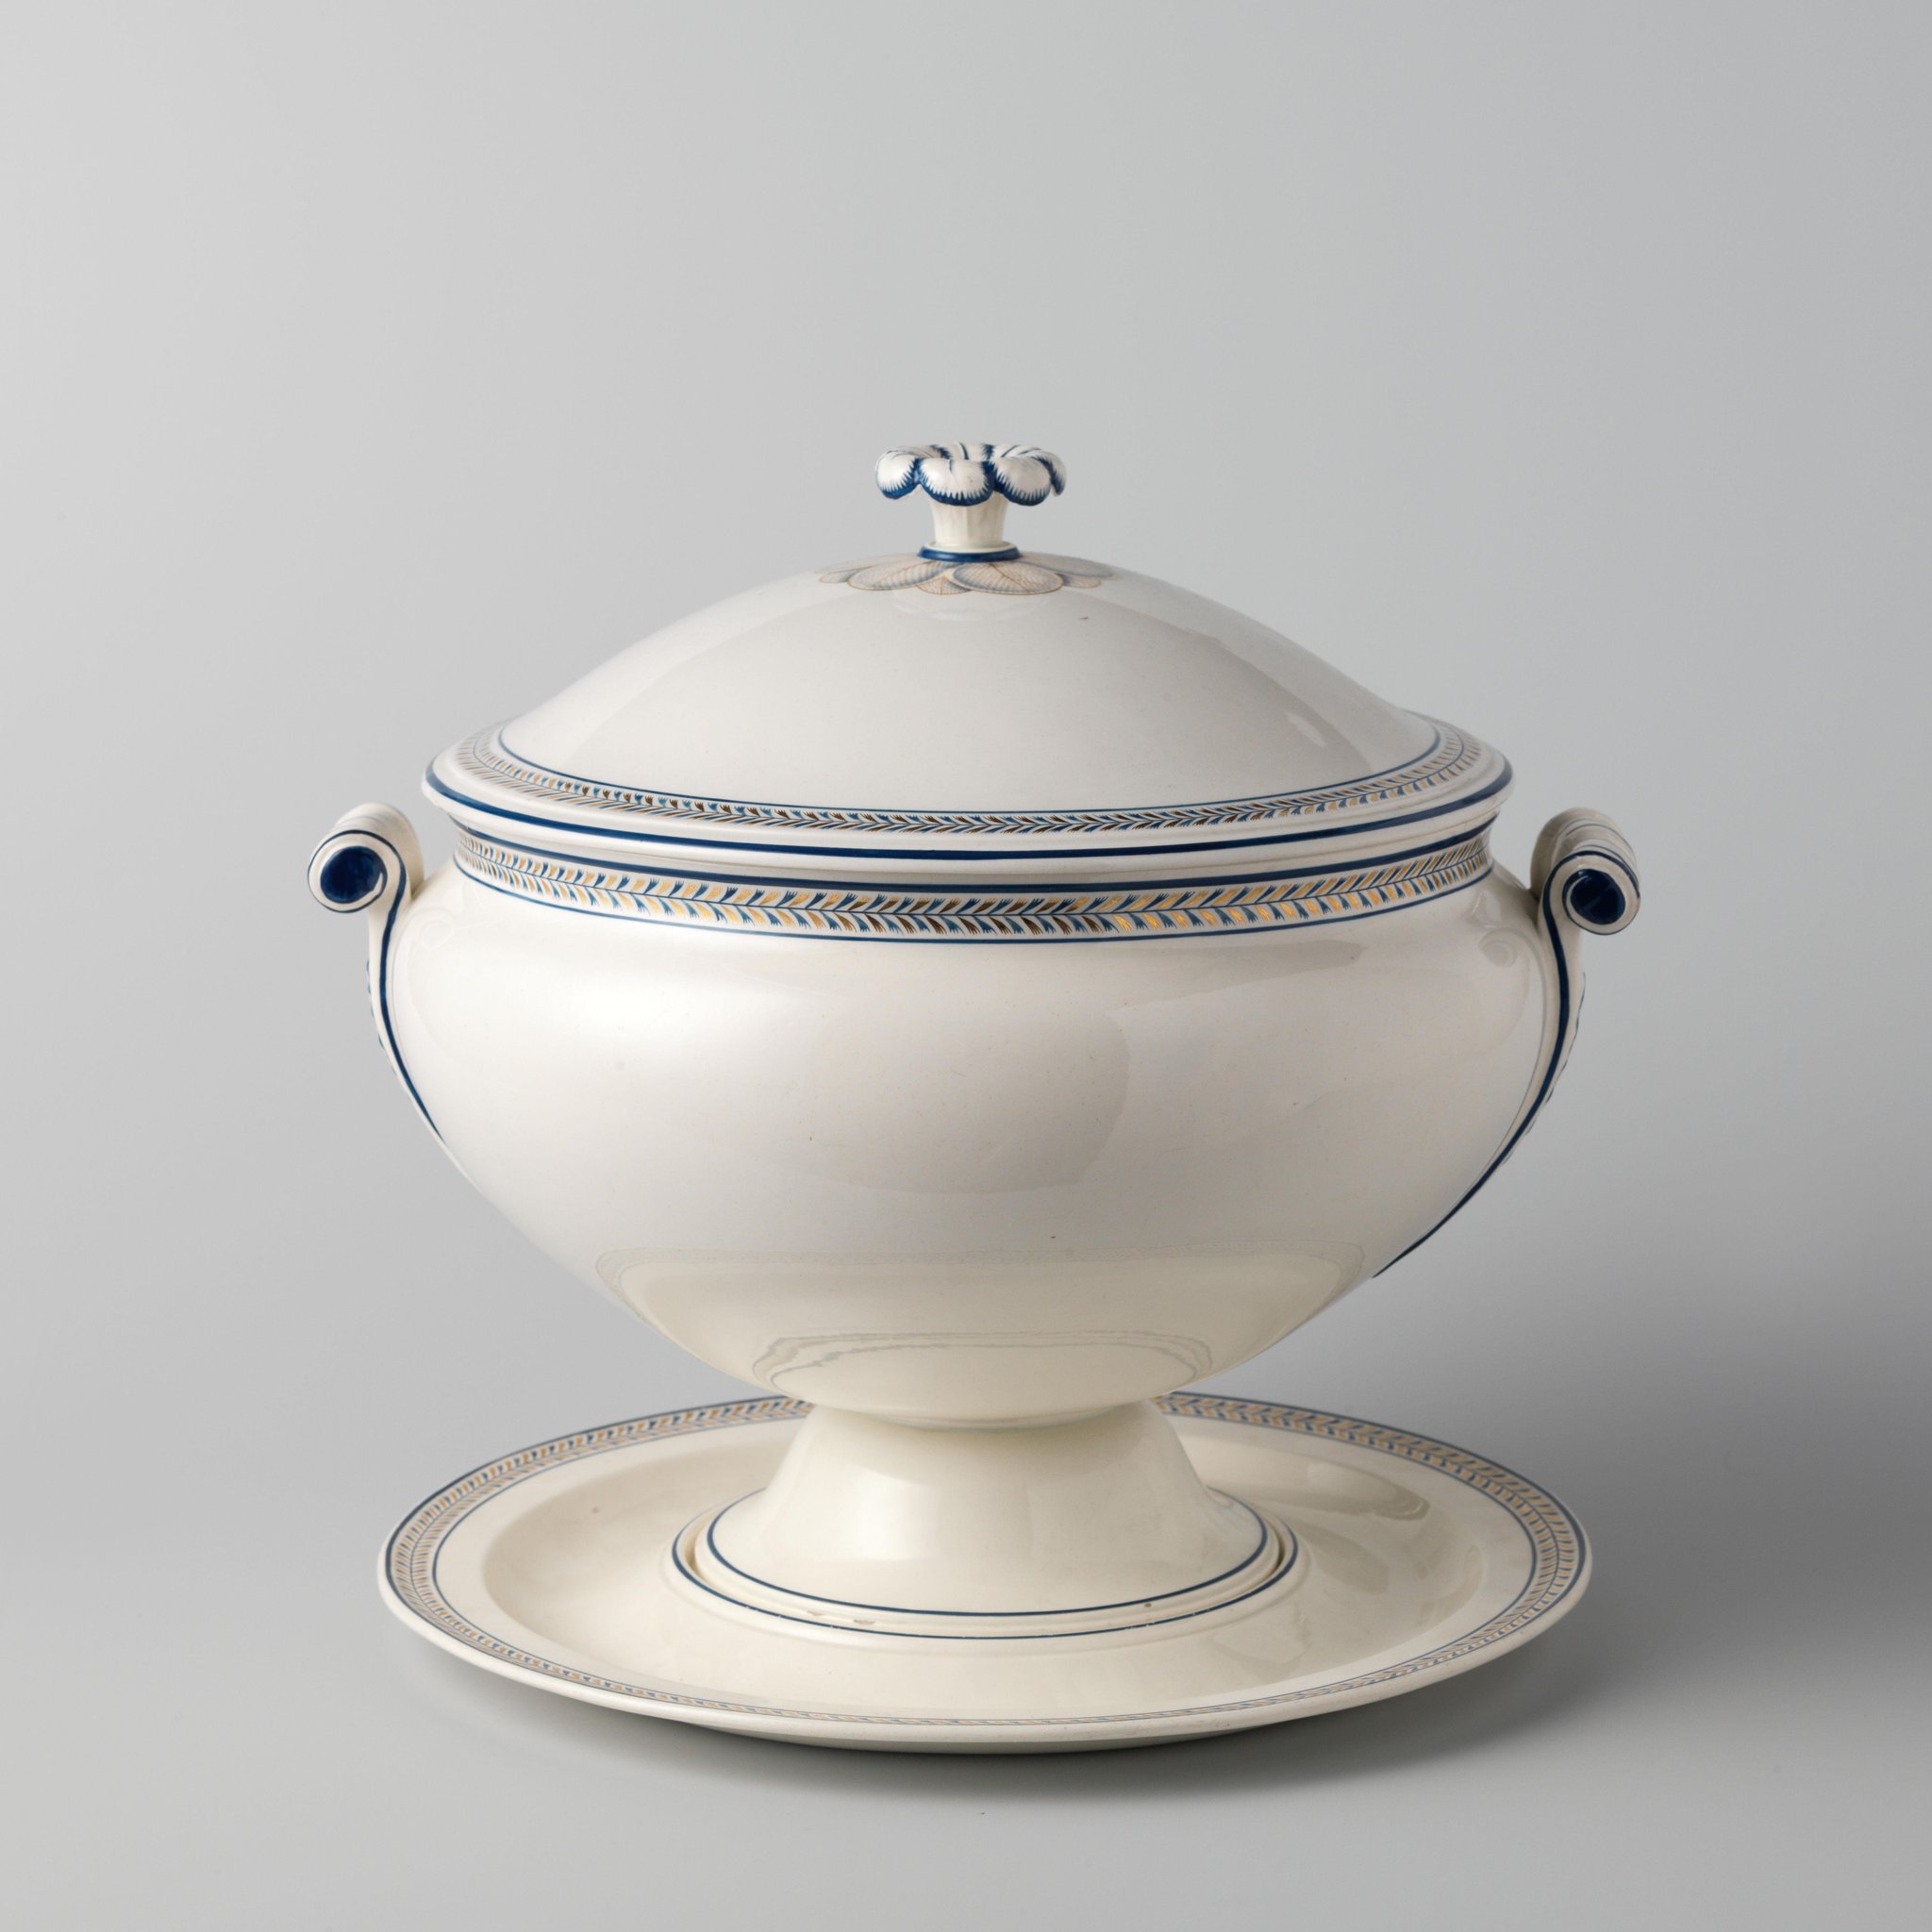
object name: platter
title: Terrine van hardgebakken aardewerk, Wedgwood cream ware.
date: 1800-1815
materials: earthenware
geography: england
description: Terrine van hardgebakken aardewerk. De terrine is rond en heeft een gewelfde voet en een zich naar beneden verjongend lichaam. De terrine heeft voluutvormige oren.